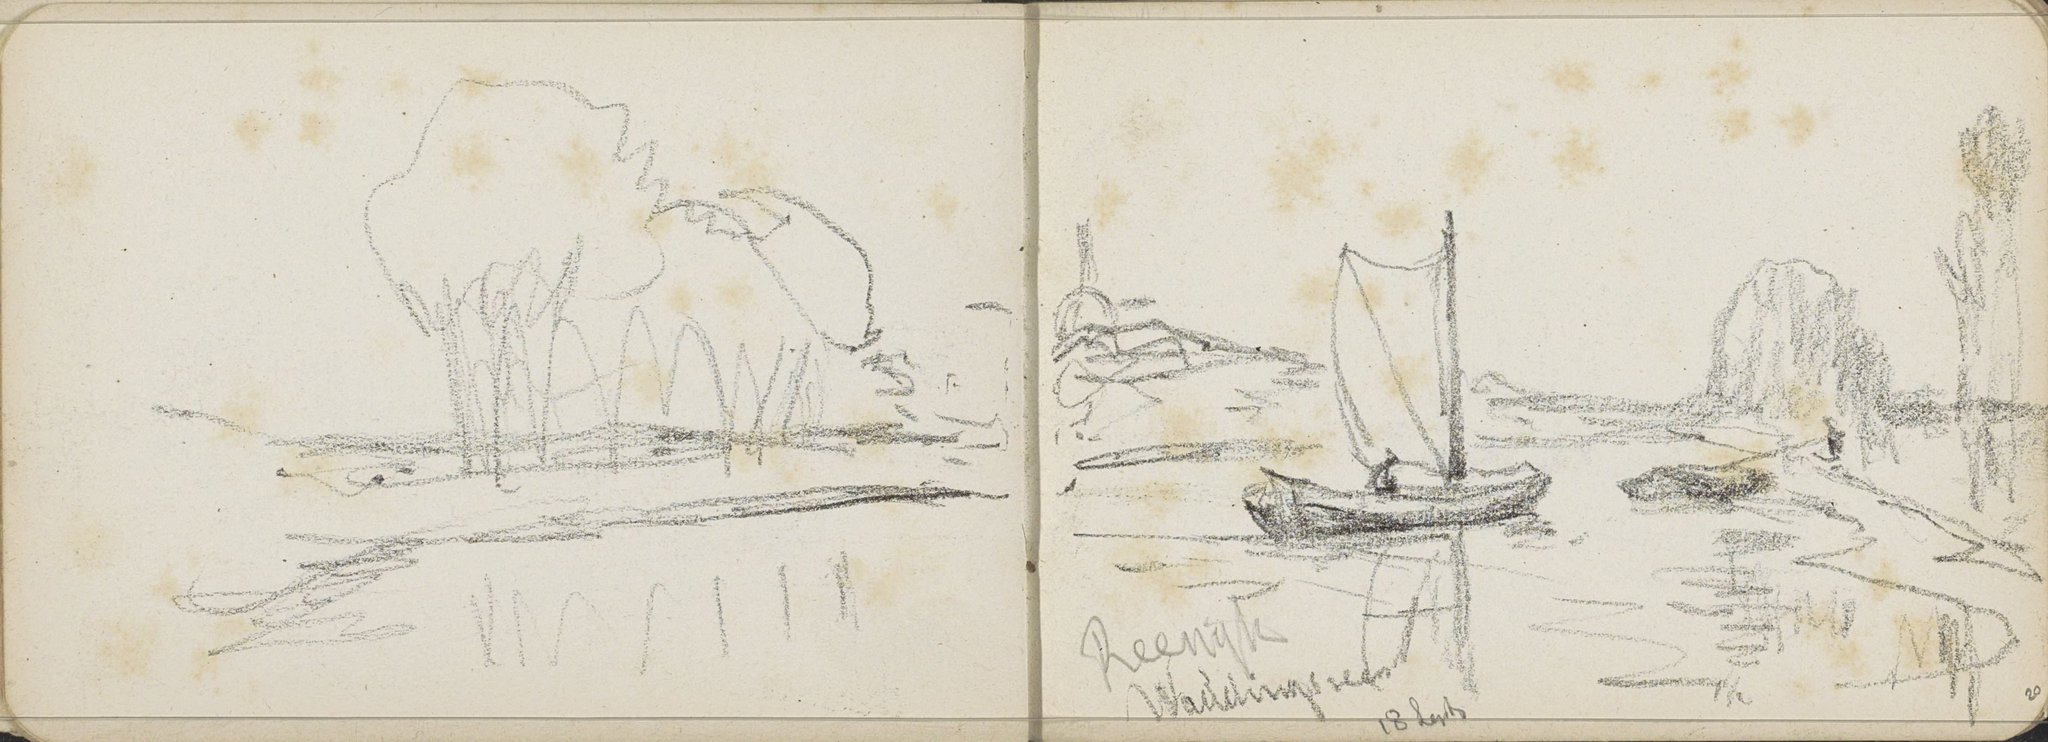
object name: sketchbook leaf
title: Zeilboot op een vaart bij Reeuwijk en Waddinxveen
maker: willem cornelis rip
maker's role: draughtsman, painter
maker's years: 1856-1922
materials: chalk, paper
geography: reeuwijk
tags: sailing-ship, sailing-boat, landscapes with waters, waterscapes, seascapes (in the temperate zone)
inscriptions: date and inscription: ‘Reewijk/ Waddingsveen/ 18 Sept’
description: Blad 19 verso en 20 recto uit een schetsboek met 44 bladen.